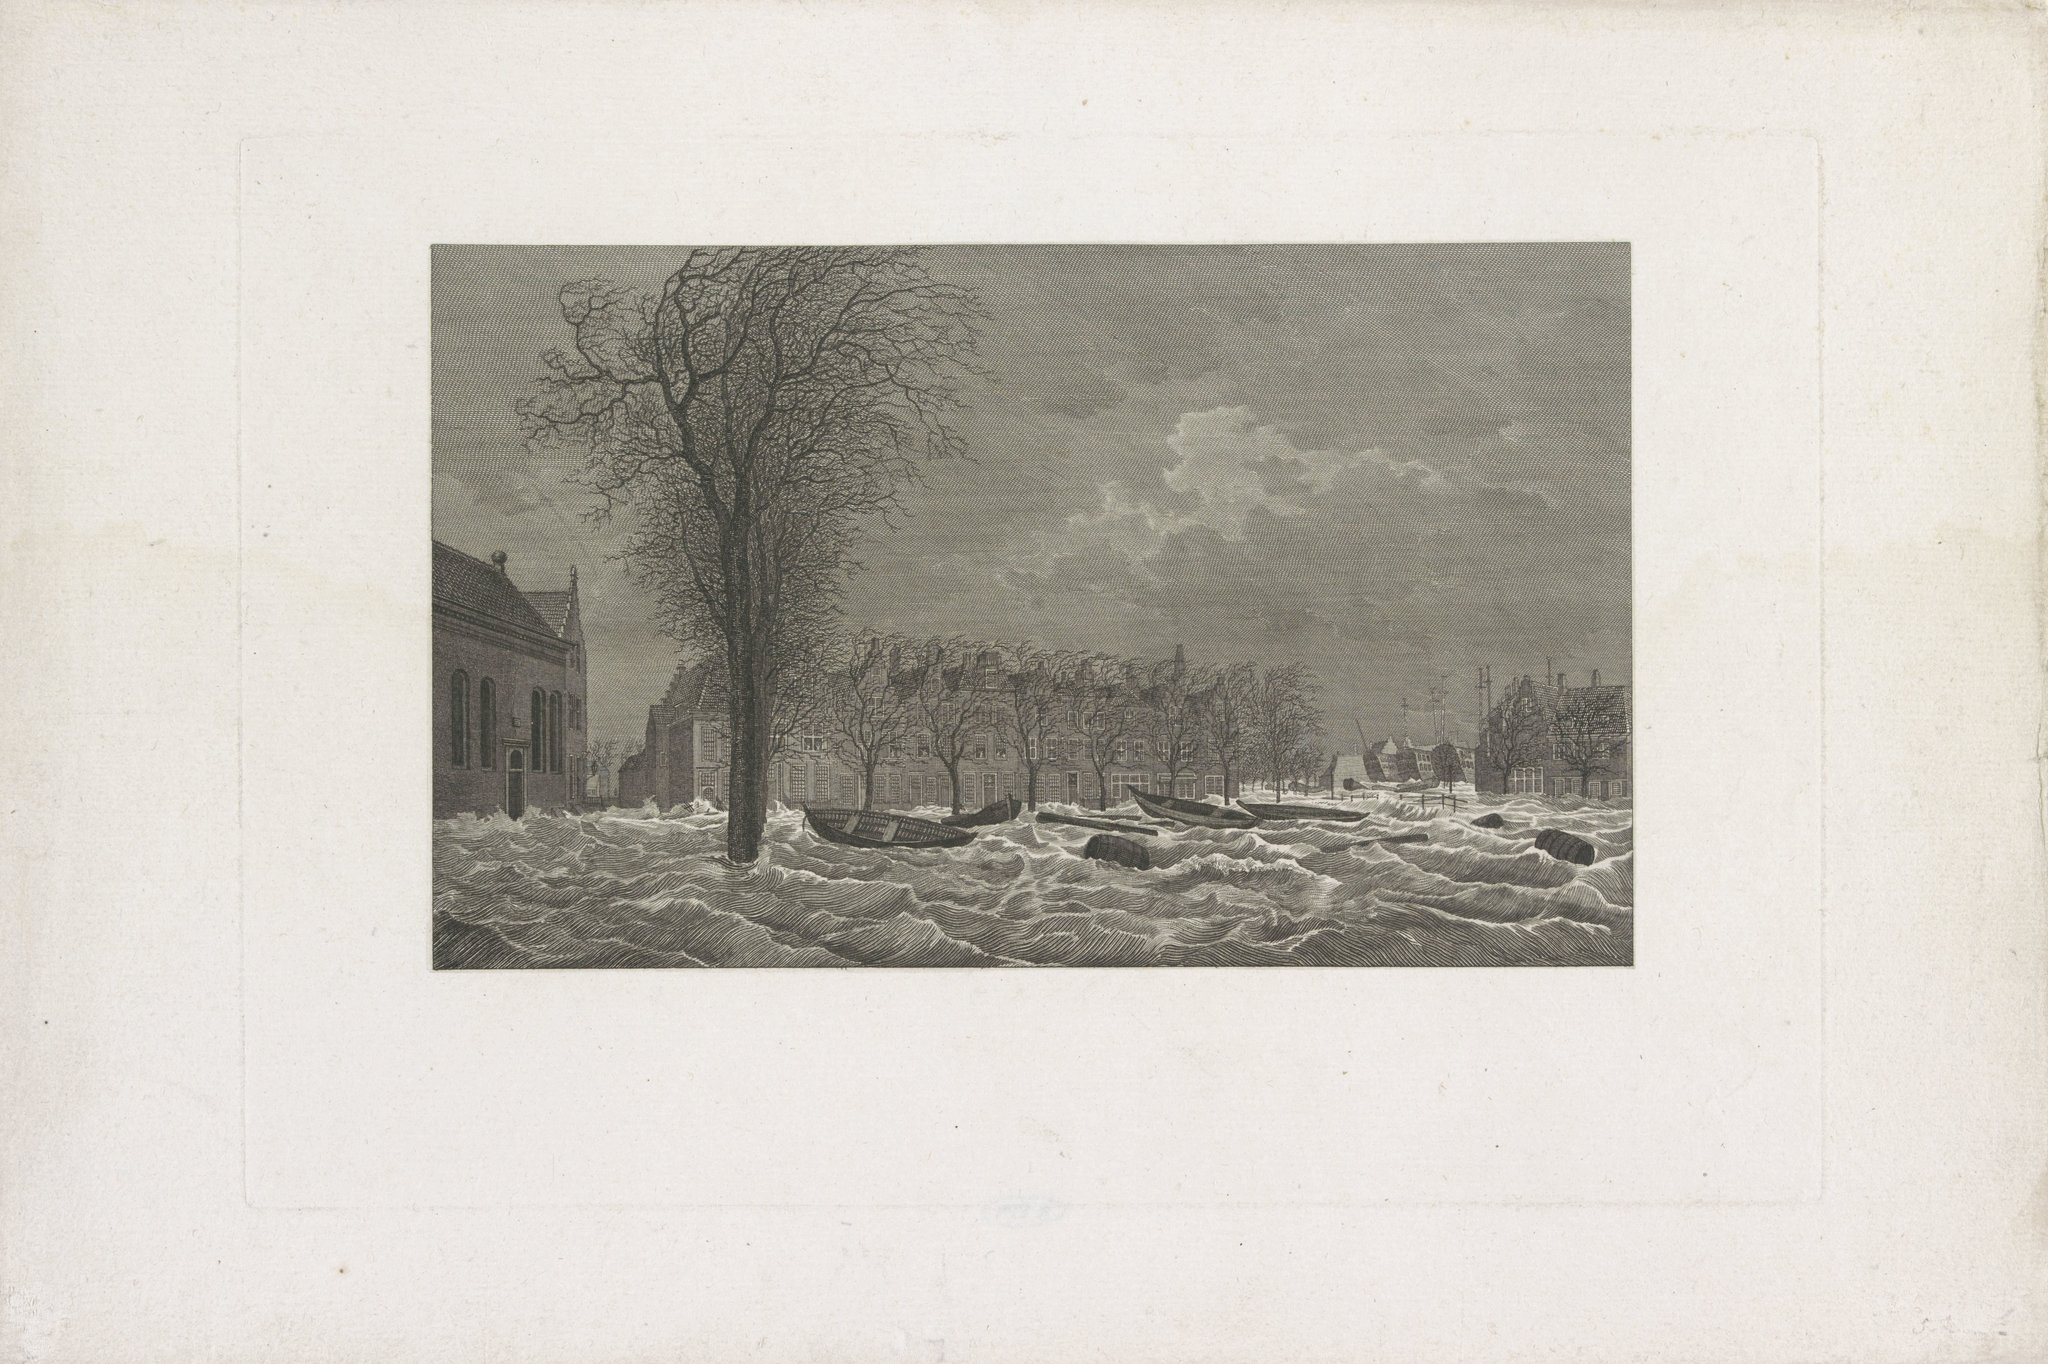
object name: print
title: Overstroming bij de Kerkstraat, Steen Beer en Dok te Vlissingen, 1808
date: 1808-1810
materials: paper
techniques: engraving, etching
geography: netherlands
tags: flood, flushing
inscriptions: collector's mark: Lugt 2228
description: Gebruikt als illustratie in: Sander van Hoek, Natuur- en geschiedkundige beschrijving van den verschrikkelijken watervloed tusschen den XIVden en XVden van louwmaand des jaars MDCCCVIII. 3 dln. Haarlem: Adriaan Loosjes Pz., 1808-1810.